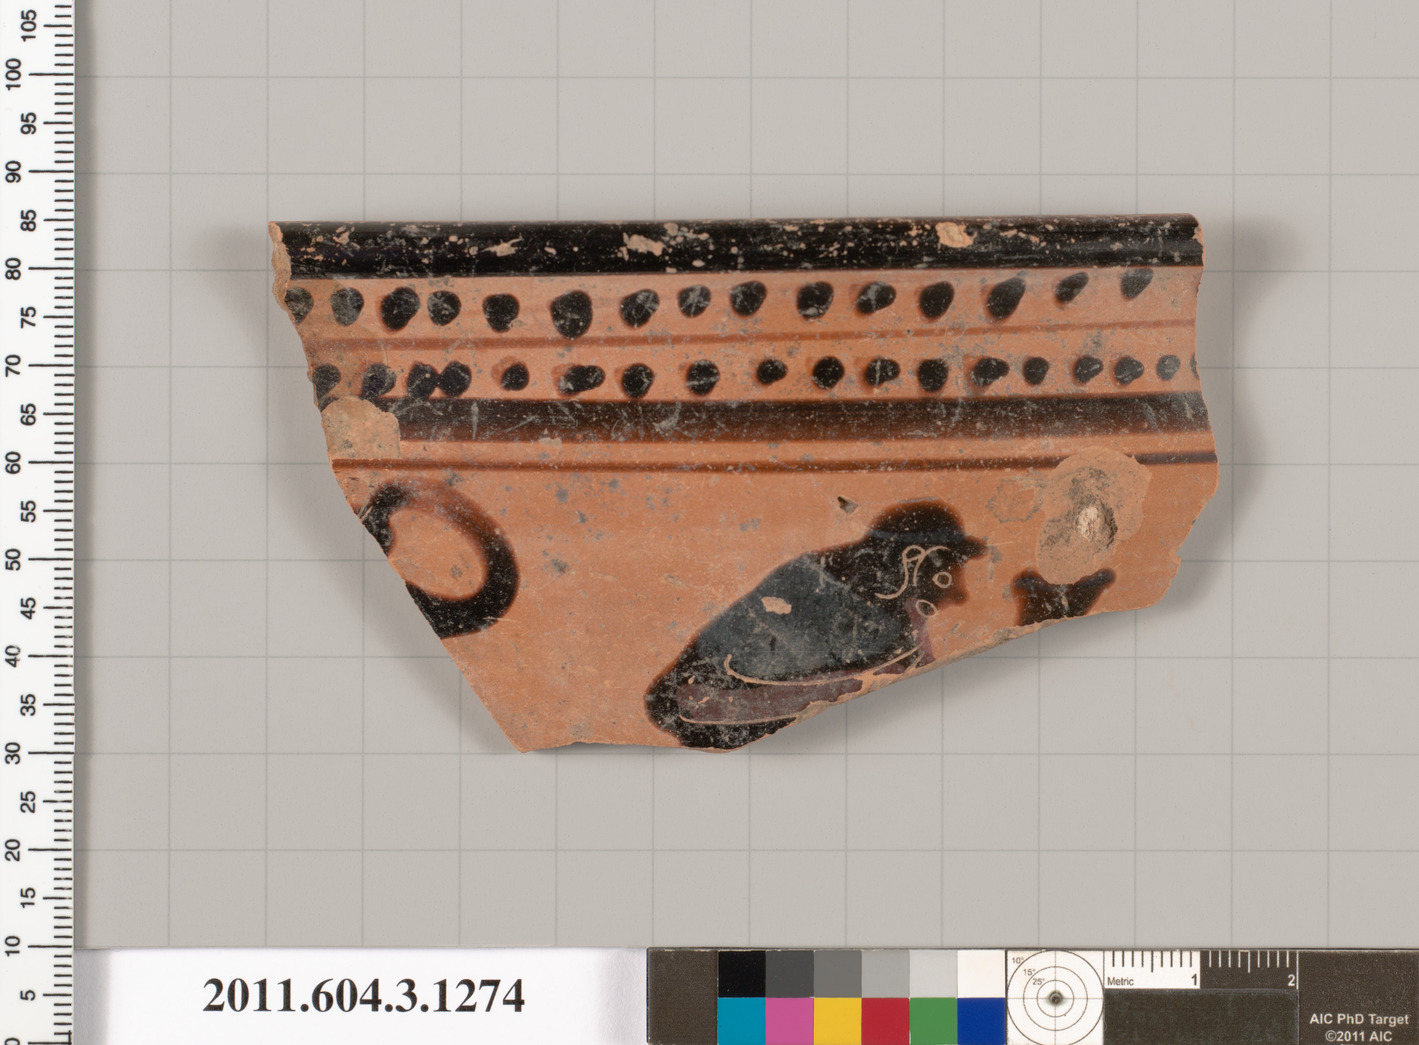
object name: skyphos fragment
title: Terracotta rim fragment of a skyphos (deep drinking cup)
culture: greek, attic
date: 500 BCE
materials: terracotta